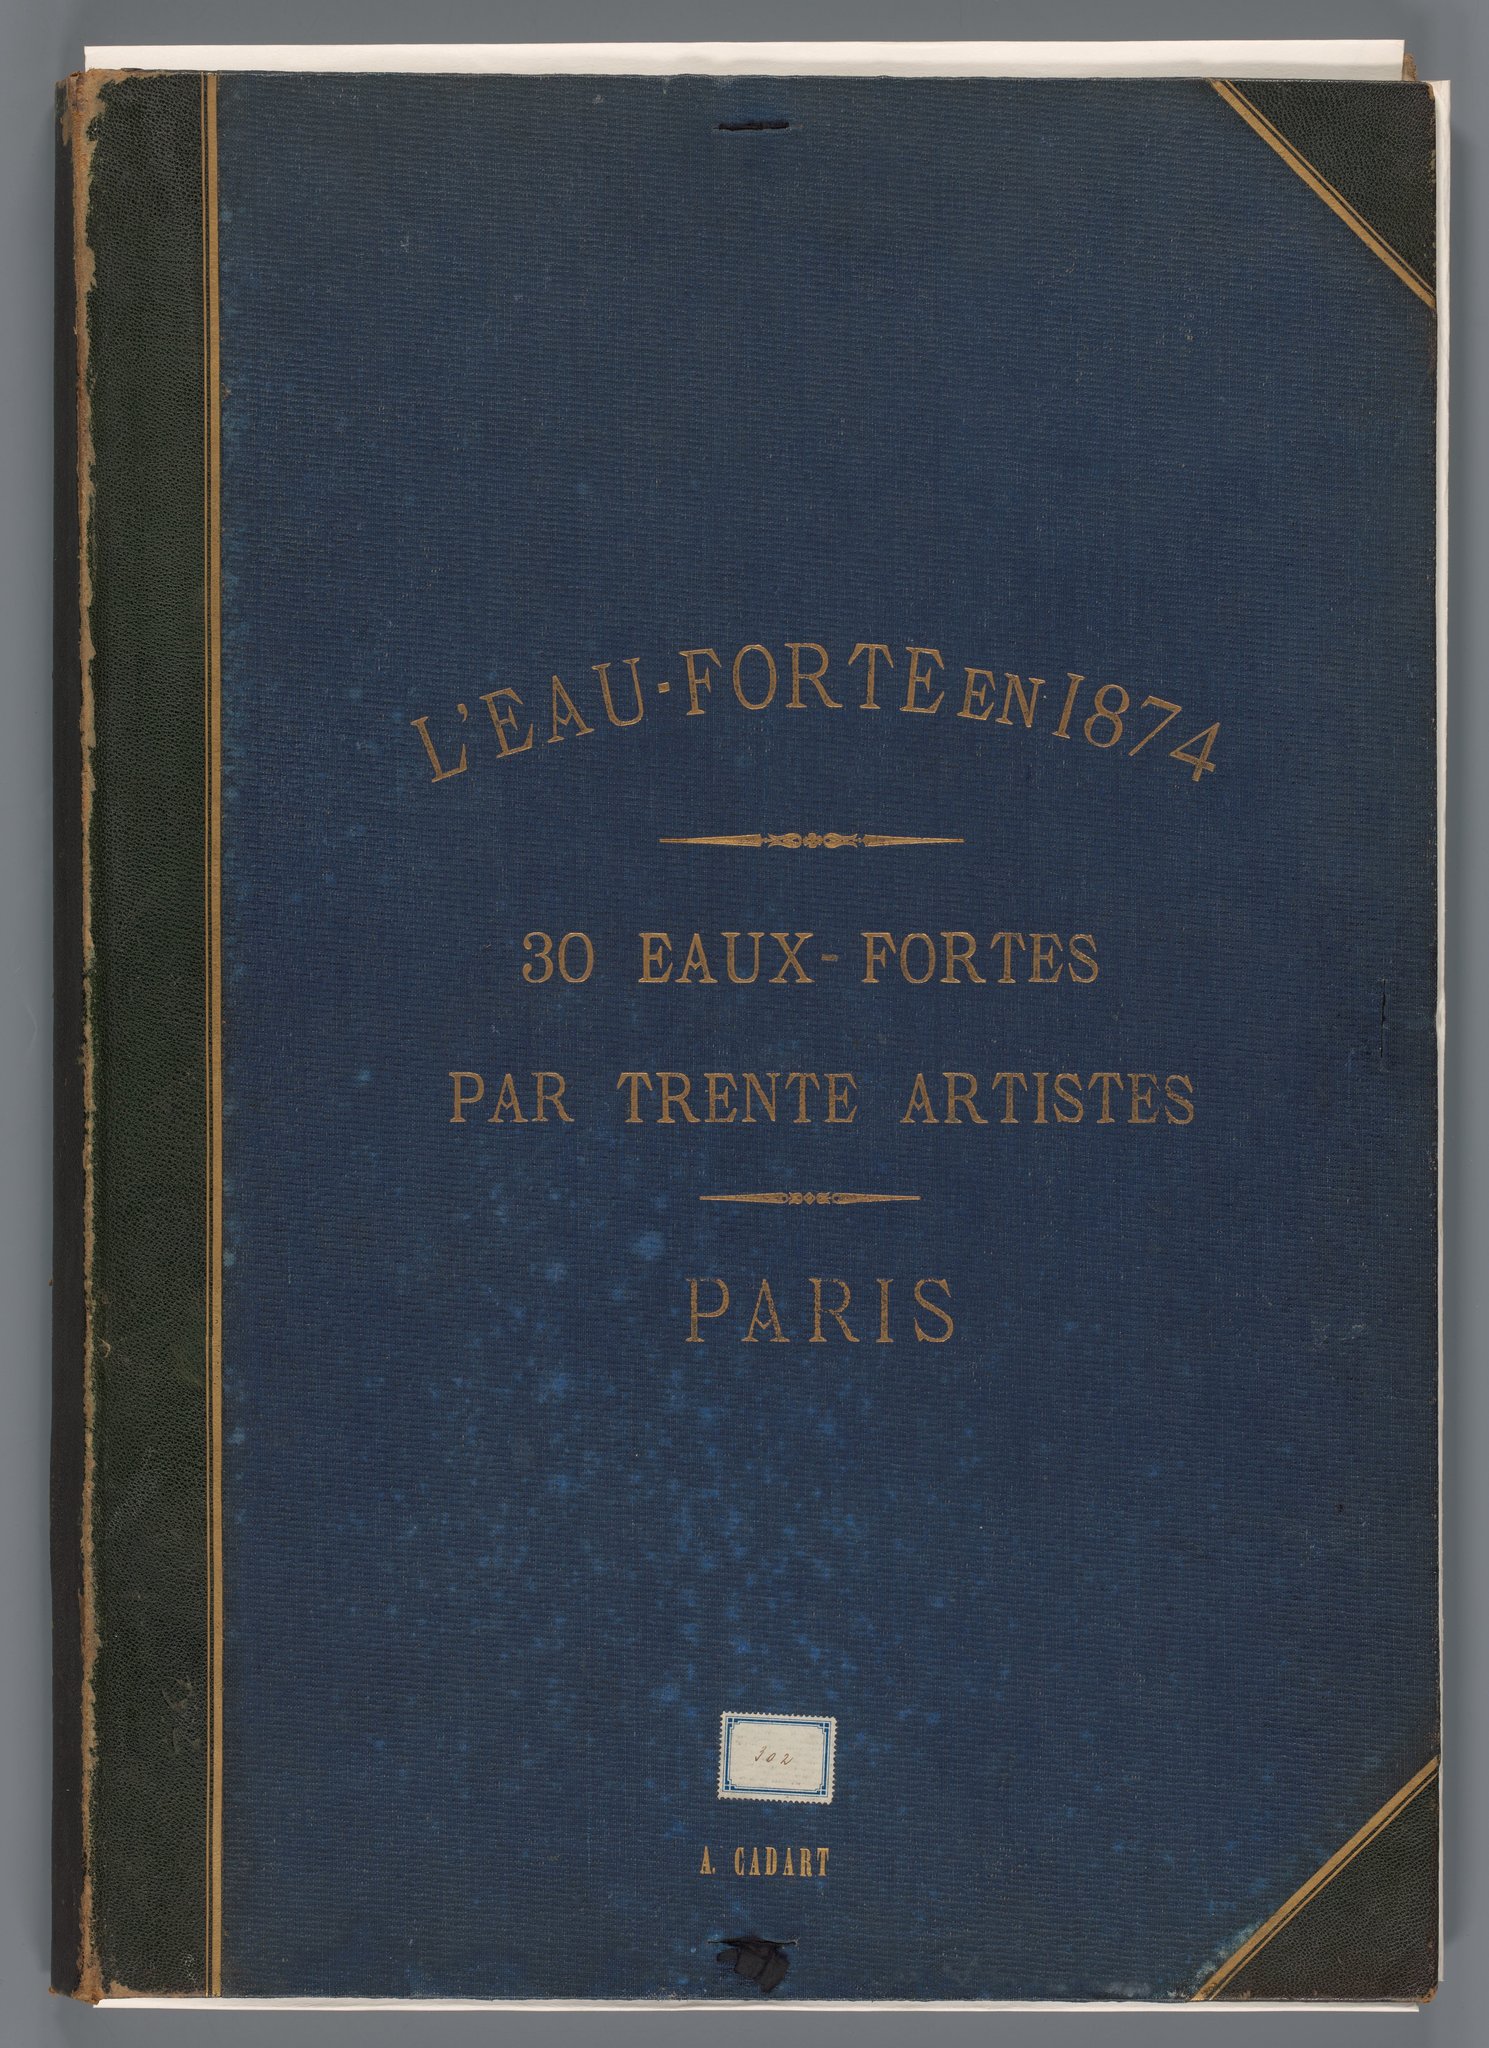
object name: wrapper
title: L'eau-forte en 1874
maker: alfred cadart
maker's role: print maker, printer, publisher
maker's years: 1828-1875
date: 1874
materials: cardboard, leather, paper, ribbon, textile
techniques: gold embossing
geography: paris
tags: city-view, and landscape with man-made constructions, landscapes, historical persons - bb - woman, horse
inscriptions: number: ‘302’, collector's mark: Lugt 2760, collector's mark: ‘AFE v S’, collector's mark: Lugt 2228